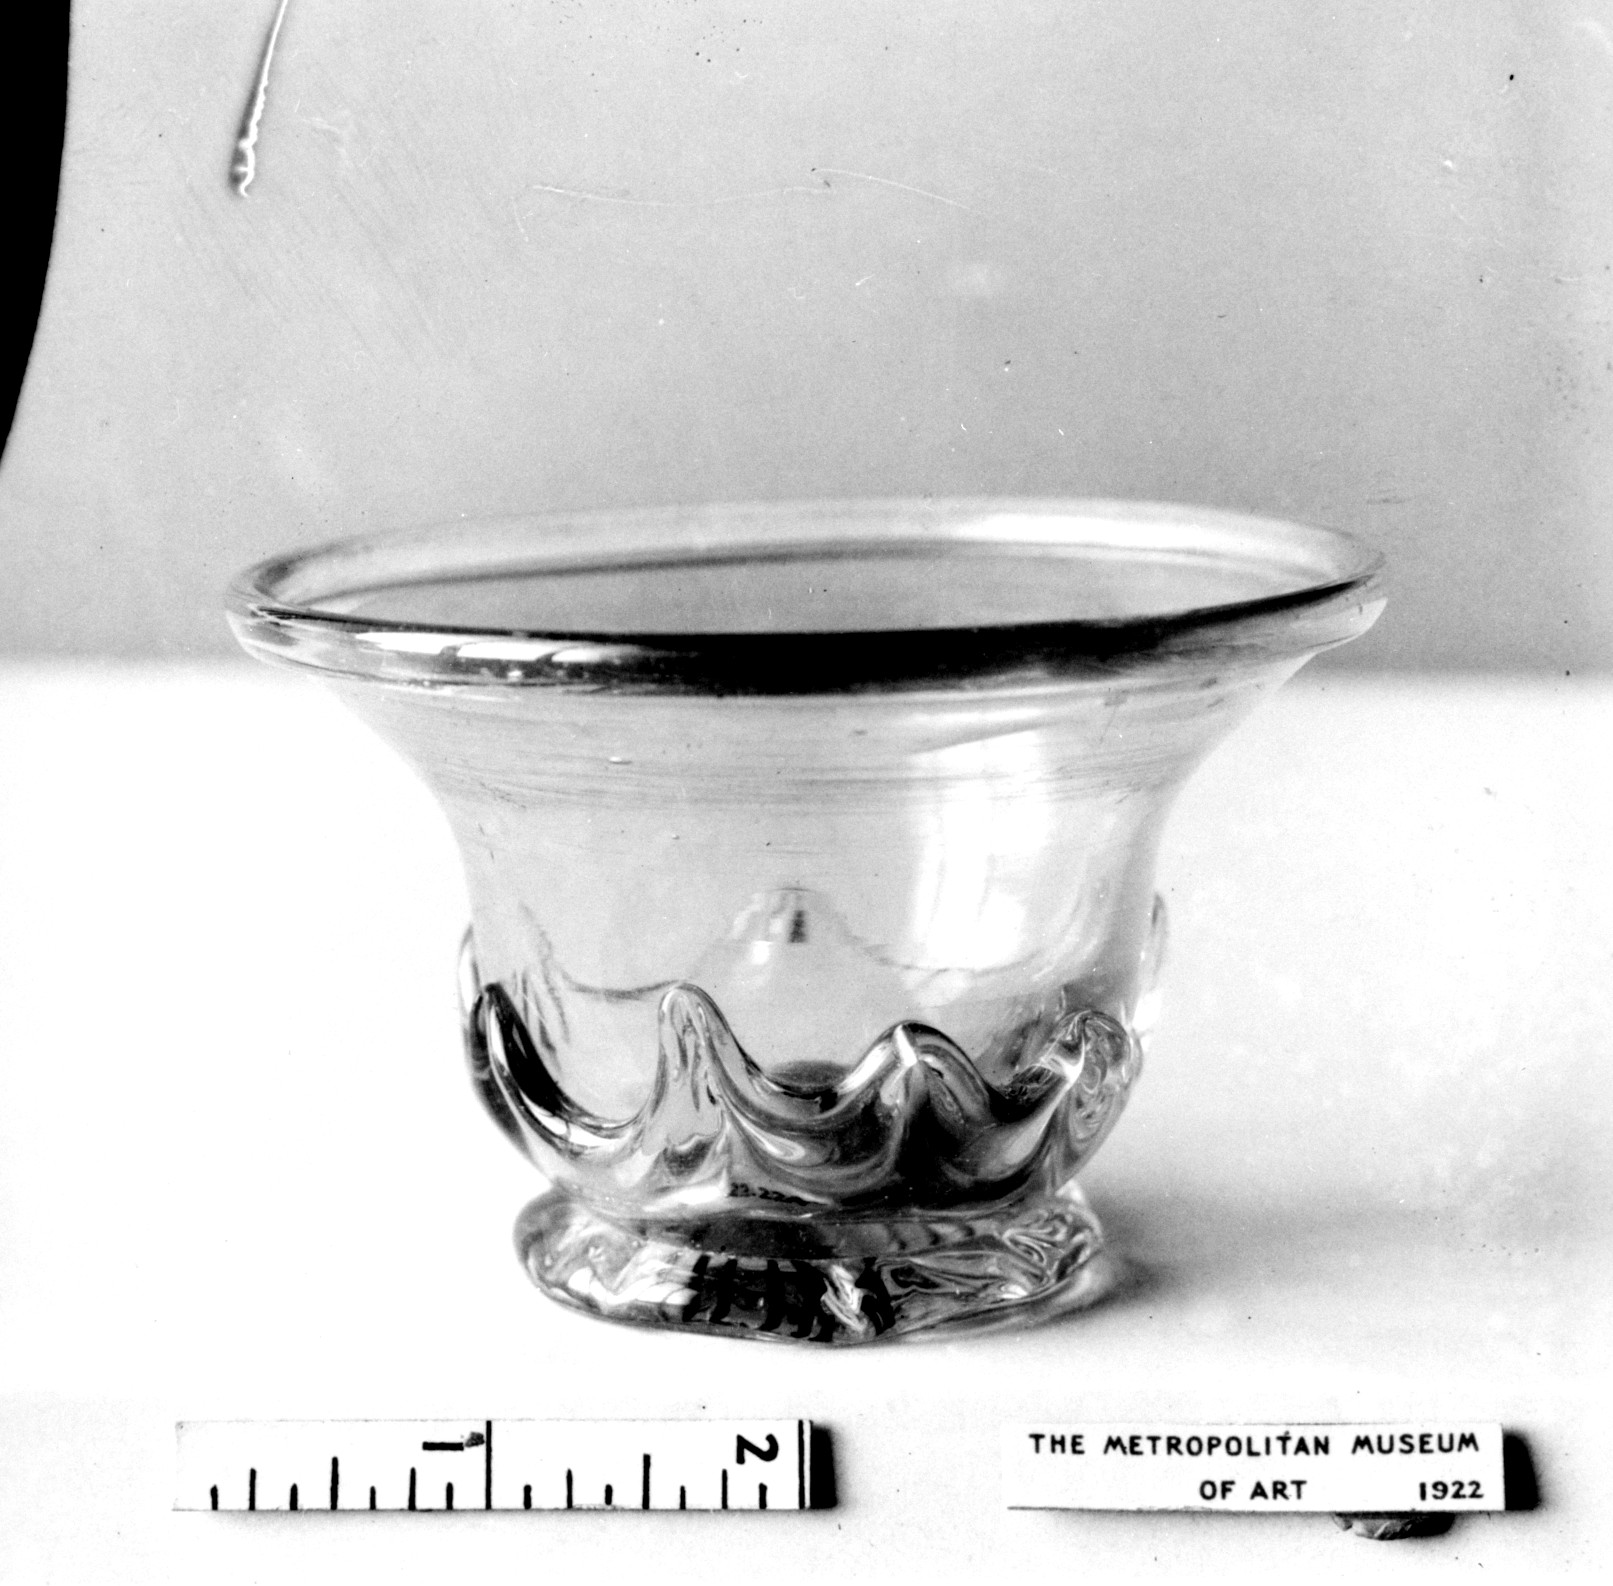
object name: bowl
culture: american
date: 1830-1850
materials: glass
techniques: glassblowing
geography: united states